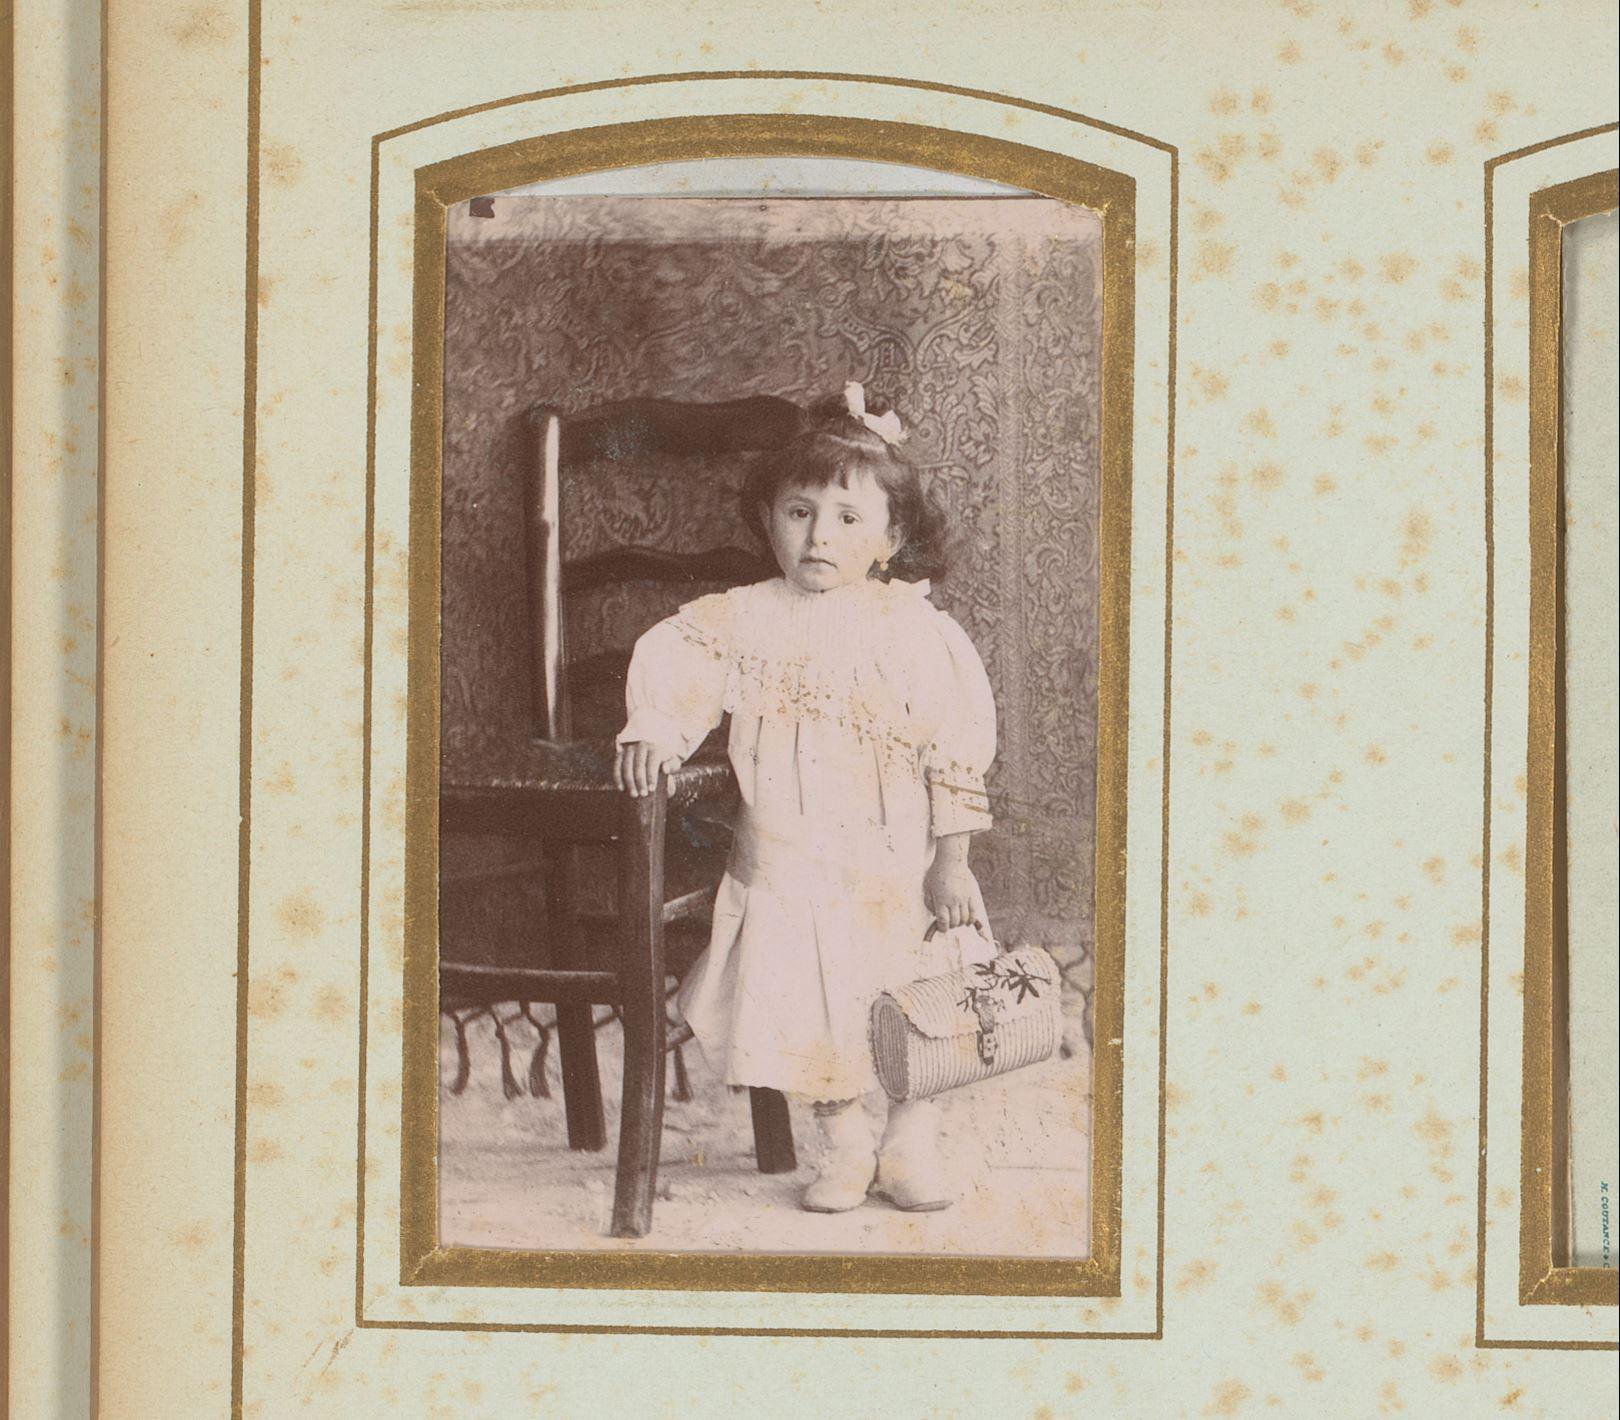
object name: album leaf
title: Portret van een meisje met strik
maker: Anonymous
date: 1880-1920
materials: cardboard, photographic support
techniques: gelatin silver print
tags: girl (child between toddler and youth)